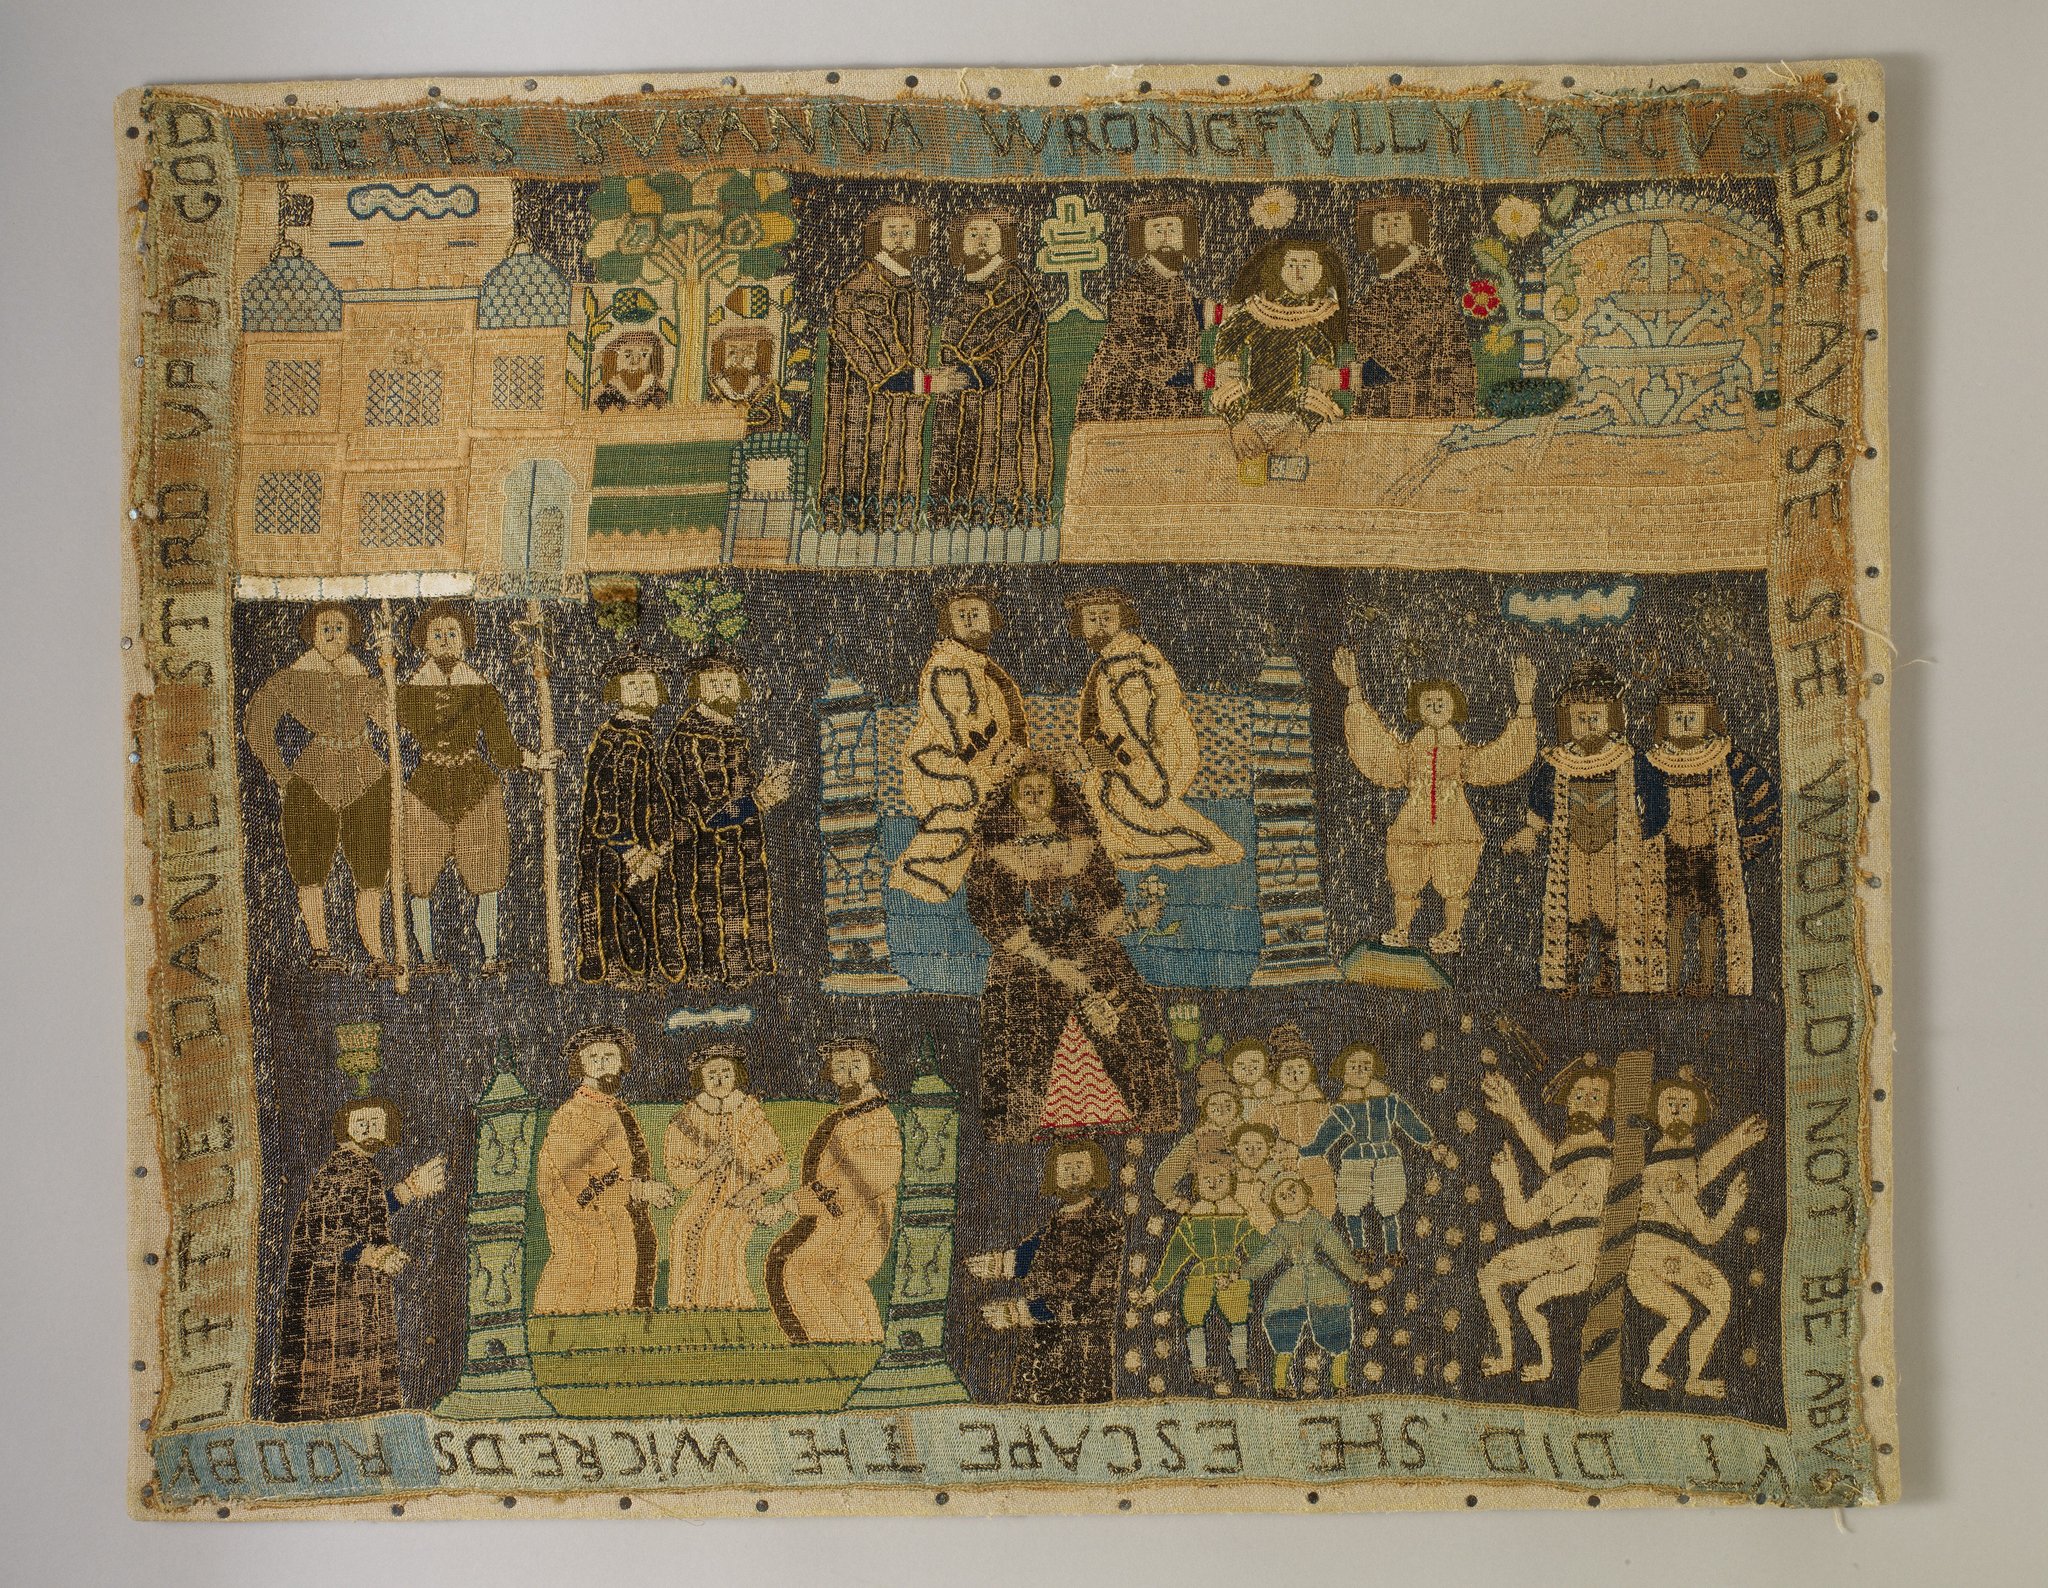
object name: embroidered picture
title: Picture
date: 1626-1650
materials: leather, linen, metal thread, silk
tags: men,women